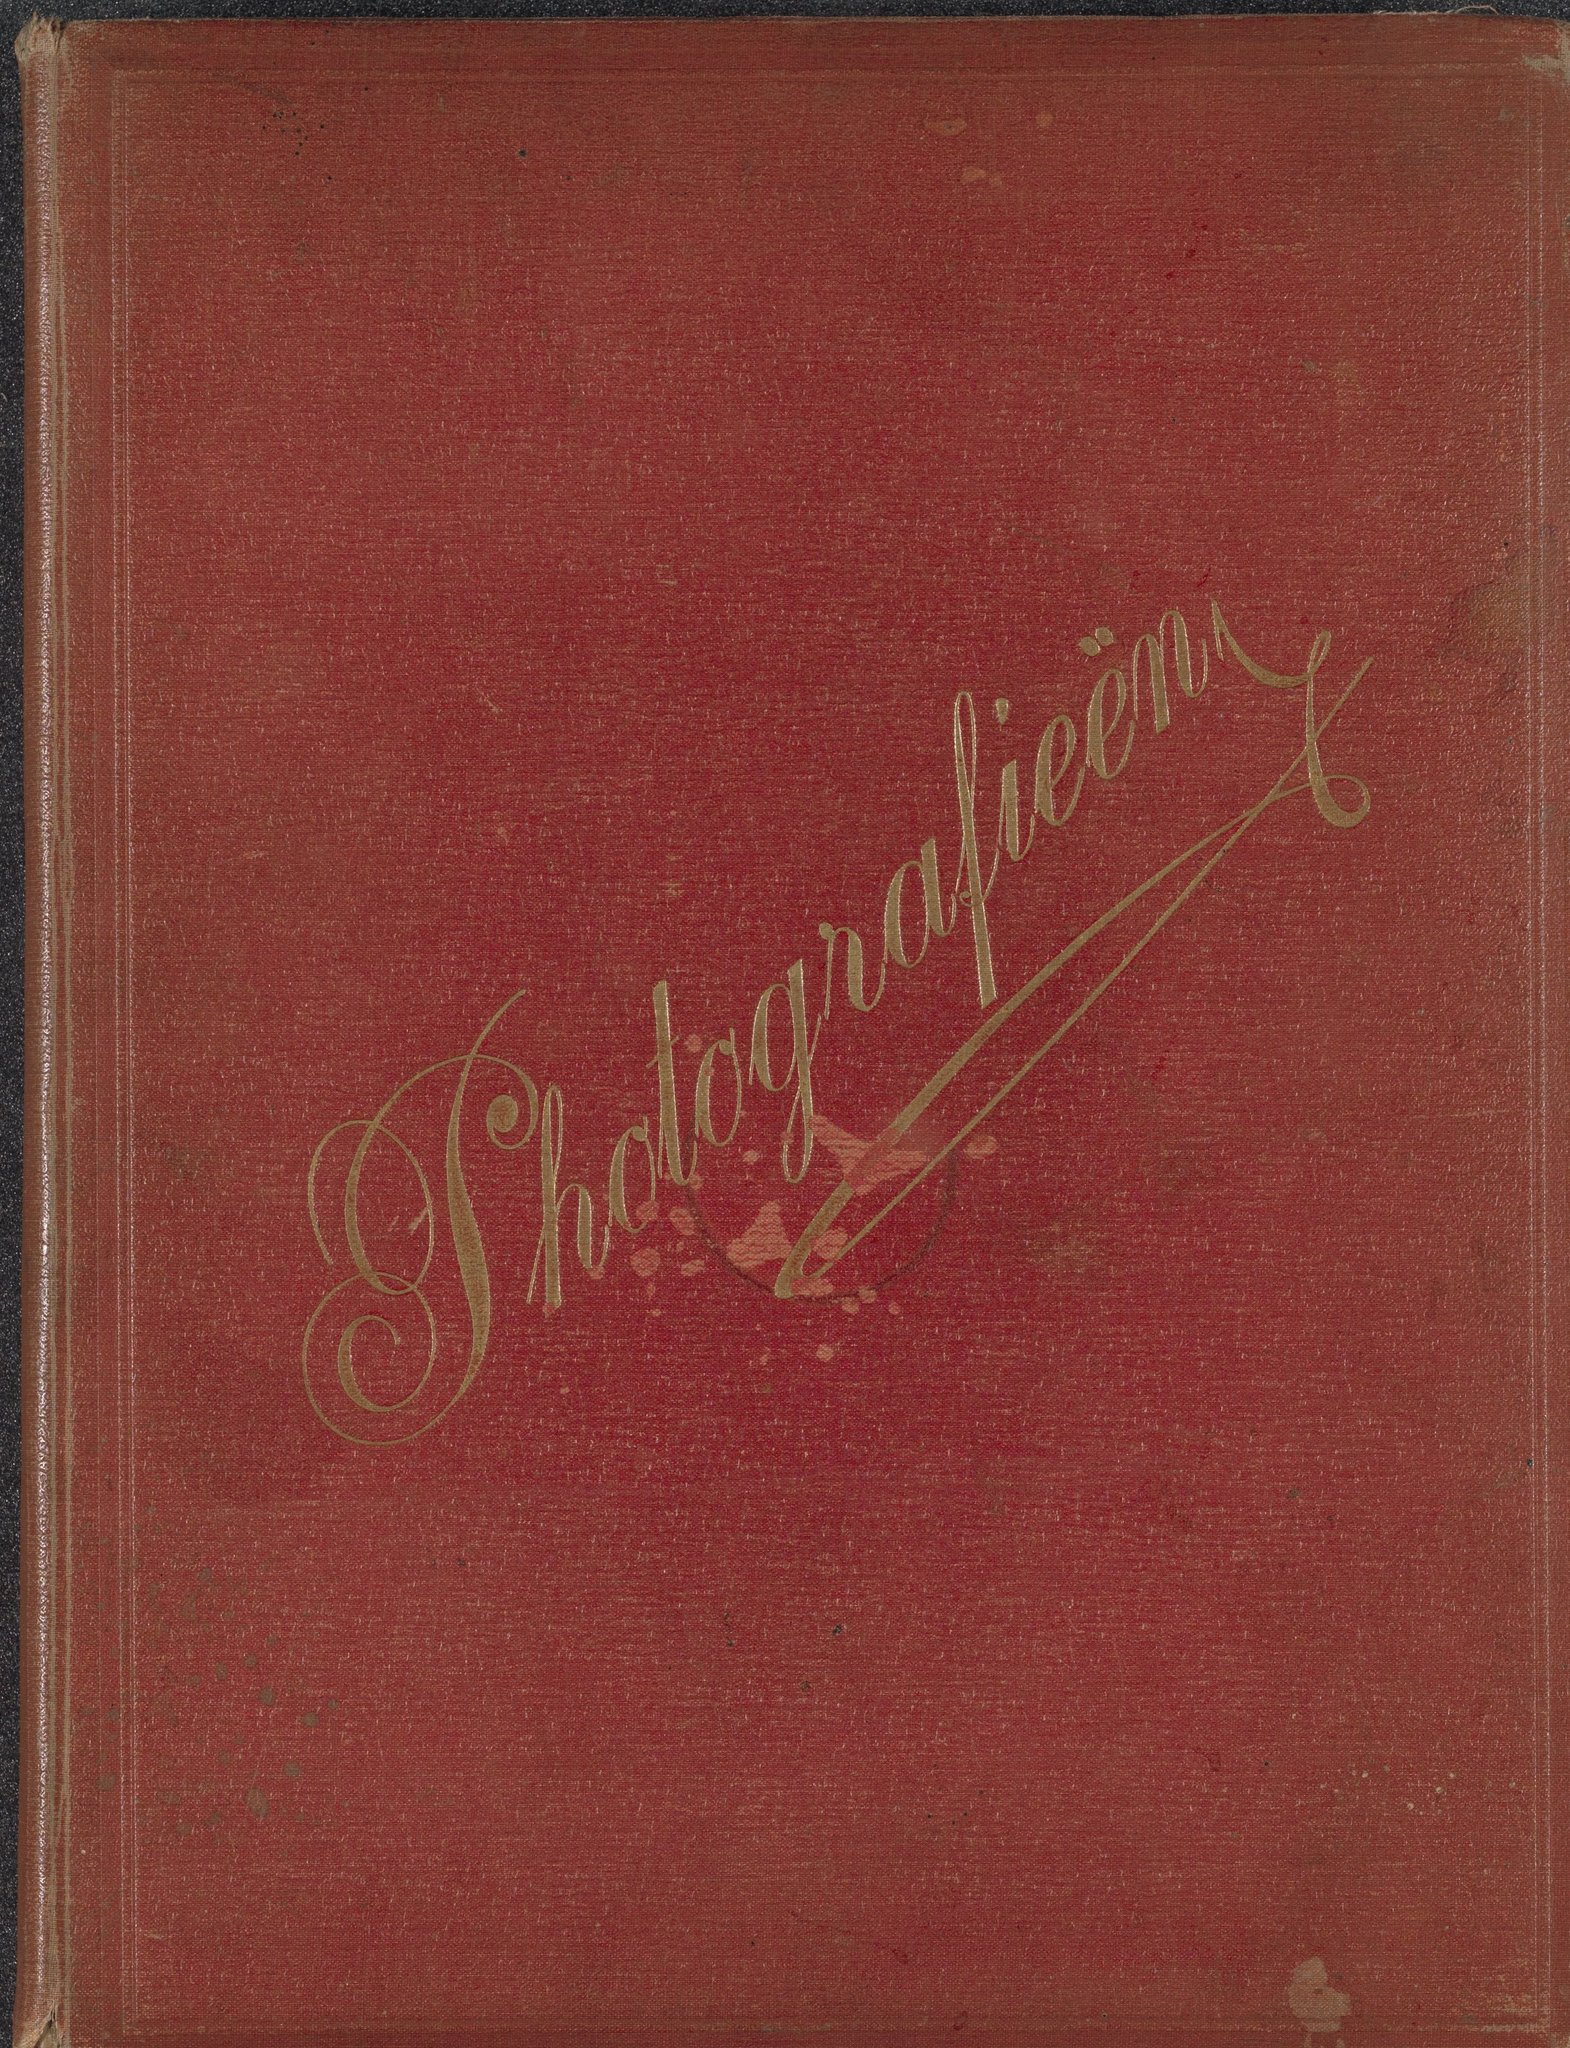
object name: photograph album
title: Photografieën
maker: Anonymous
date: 1880-1910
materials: cardboard, linen, paper, photographic support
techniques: albumen print, photograph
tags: travelling; tourism, germany, france, switzerland, england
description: Fotoalbum in rood linnen band met op het voorplat de titel 'Photografieën' in gouddruk. De schutbladen hebben een motief van groene bladeren op een goudkleurig raster. Het album bevat 32 bladen met goud op snee en 80 foto's, waarvan 4 los werden aangetroffen. Het zijn voornamelijk opnames van straten, bruggen, pleinen en gebouwen in Londen, Brighton en Windsor. Van deze foto's bevindt zich in het album een handgeschreven lijst van onderwerpen. Voorts bevat het album stads- en straatgezichten en berglandschappen in Zwitserland, Frankrijk en Duitsland.